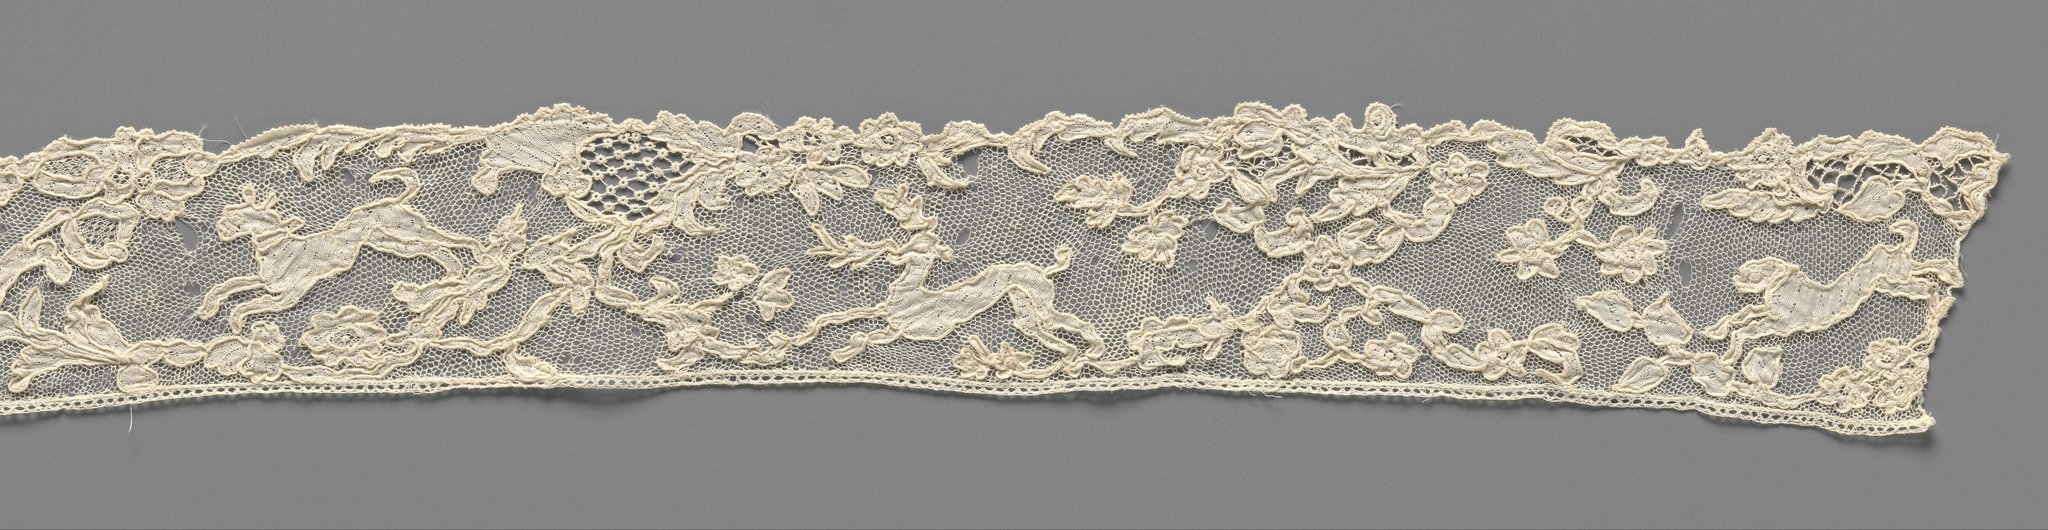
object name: strip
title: Strook naaldkant met herten en honden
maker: Anonymous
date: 1740-1760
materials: linen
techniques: lace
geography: france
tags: hoofed animals, dog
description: Strook naturelkleurige naaldkant: Alençon-kant. Het zich herhalende patroon bestaat uit een hert dat door honden wordt opgejaagd. De dieren worden omringd door ranken met veelsoortige bloemen. De motieven zijn opgebouwd uit festonsteken met uitsparingen en voorzien van reliëfcontouren. De motieven zijn met elkaar verbonden door een fijne zeshoekige maasgrond, een Alençon-grond, met overdwars gewerkte mazen. Enkele ruimtes tussen de ranken zijn gevuld met siergronden. De geschulpte bovenzijde ontstaat vanuit het patroon met de bloemenranken en is afgewerkt met zeer fijne picots. De onderzijde is afgezet met een rand kloskant.